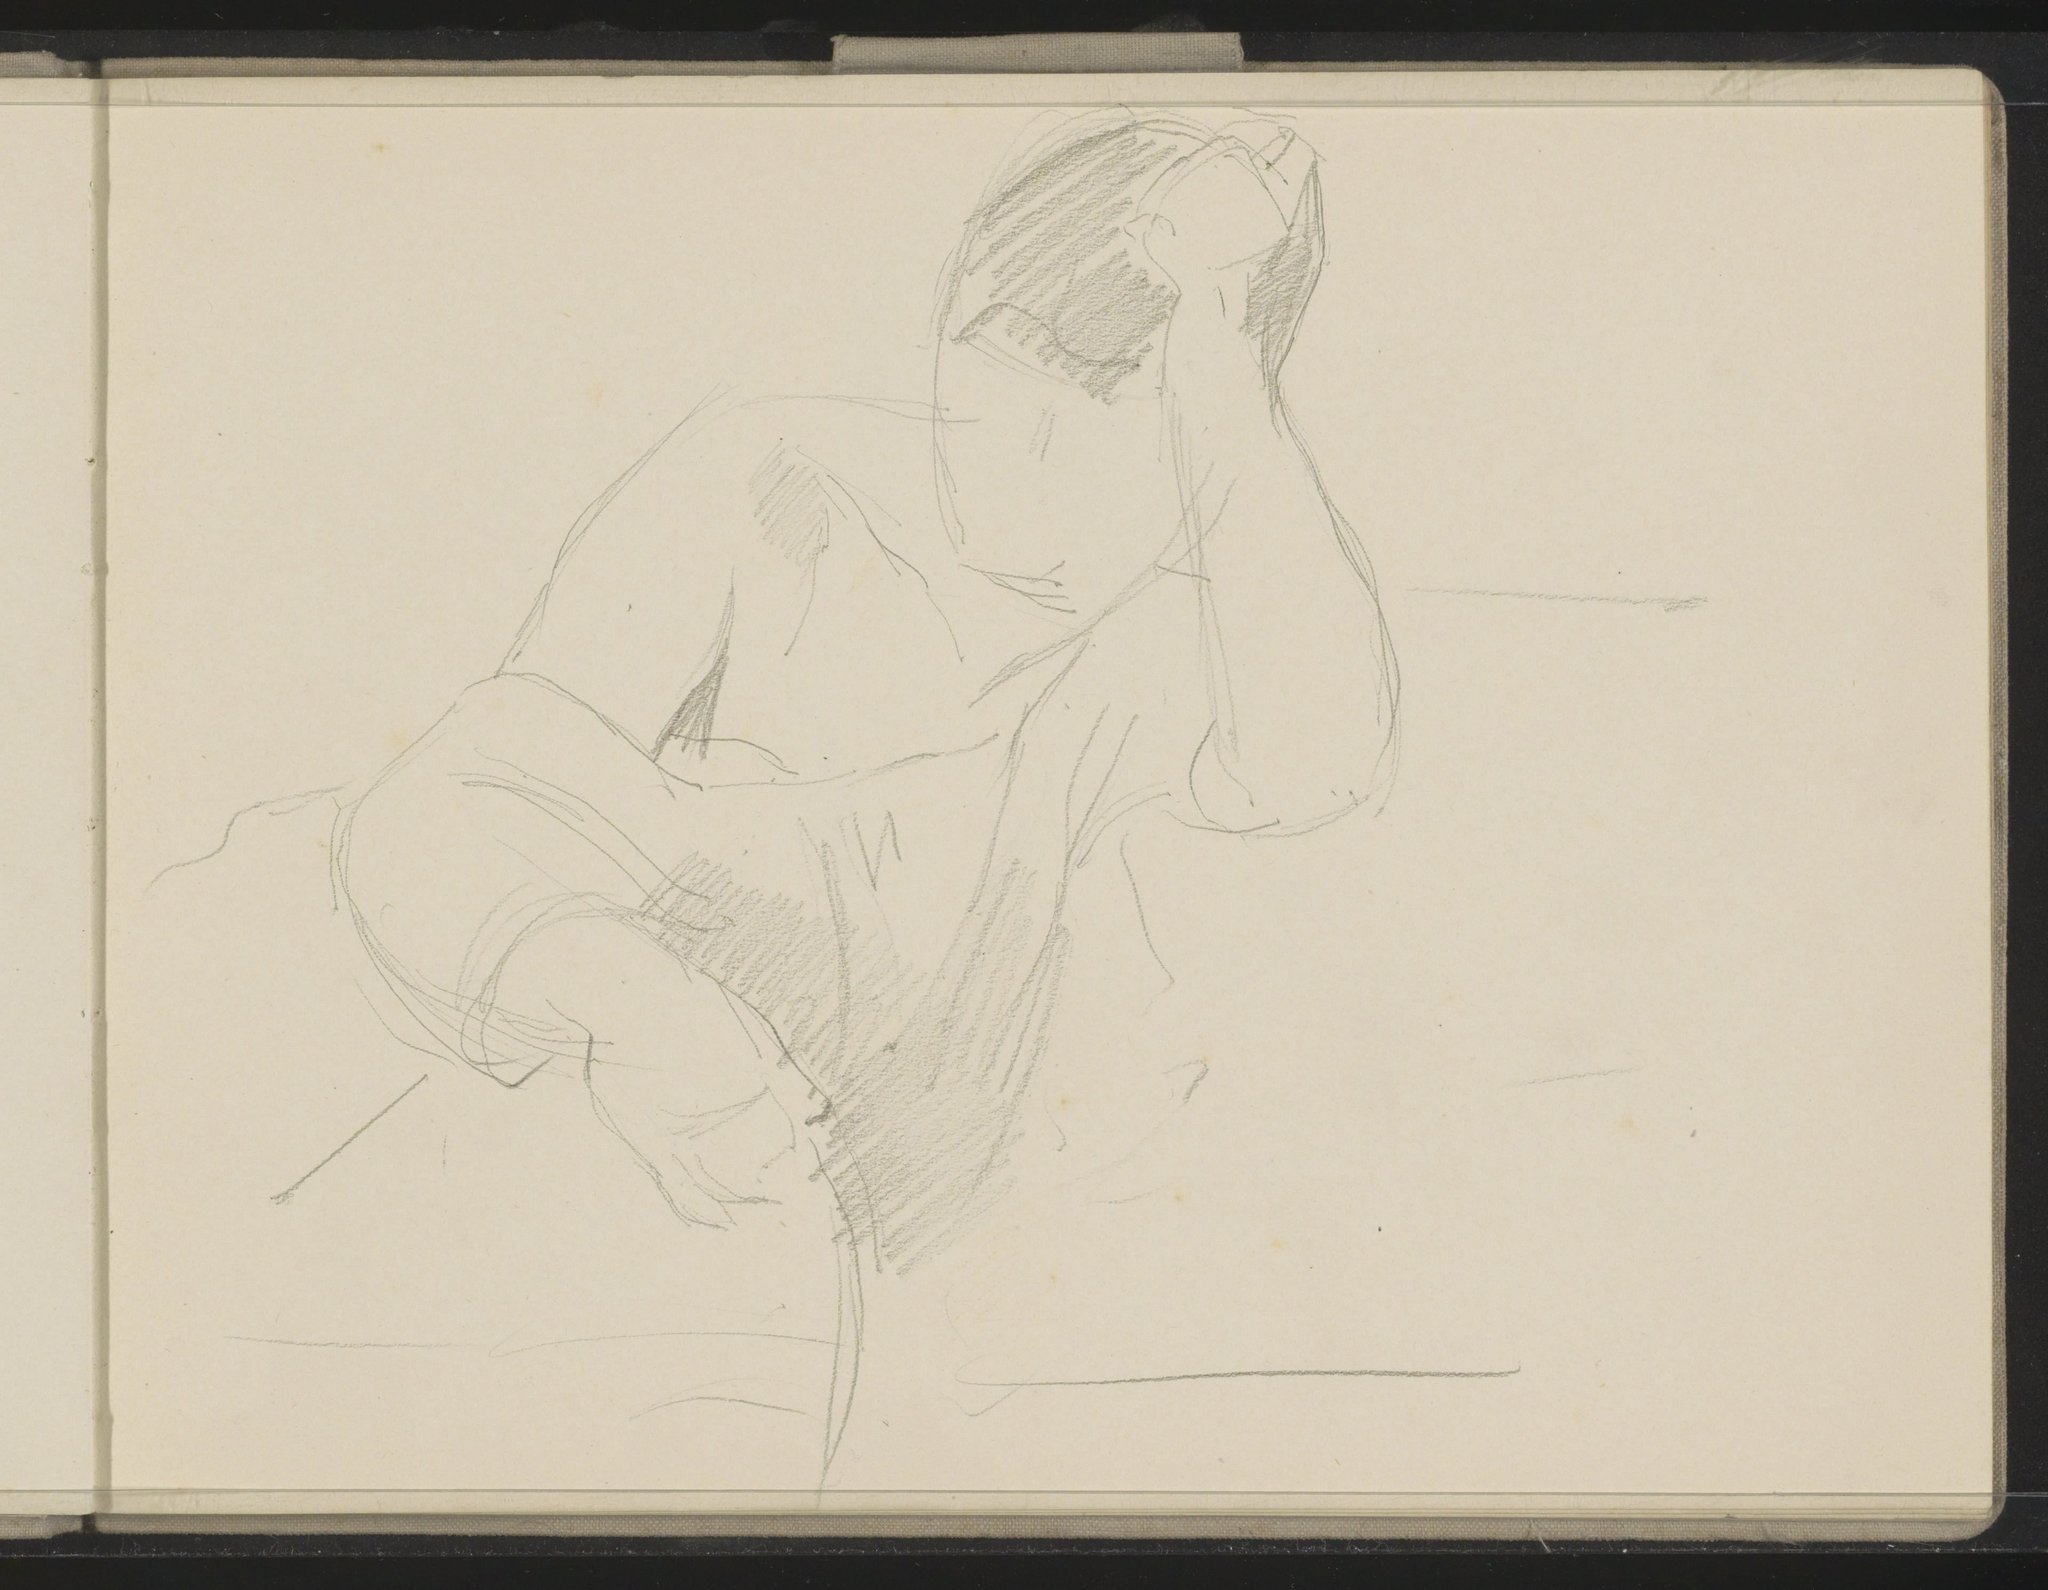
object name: sketchbook leaf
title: Zittende vrouw met ontblote schouder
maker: ferdinand oldewelt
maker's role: draughtsman, print maker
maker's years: 1857-1935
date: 1908-1923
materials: paper, pencil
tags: sitting figure - aa - female human figure, hand(s) bent towards the head (+ female (human being) (not to be used where -aa- is prescribed))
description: De vrouw draagt een hemd of jurk die van haar rechterschouder is gegleden. Ze ondersteunt haar hoofd met haar hand. Blad 15 recto uit een schetsboek met 35 bladen.